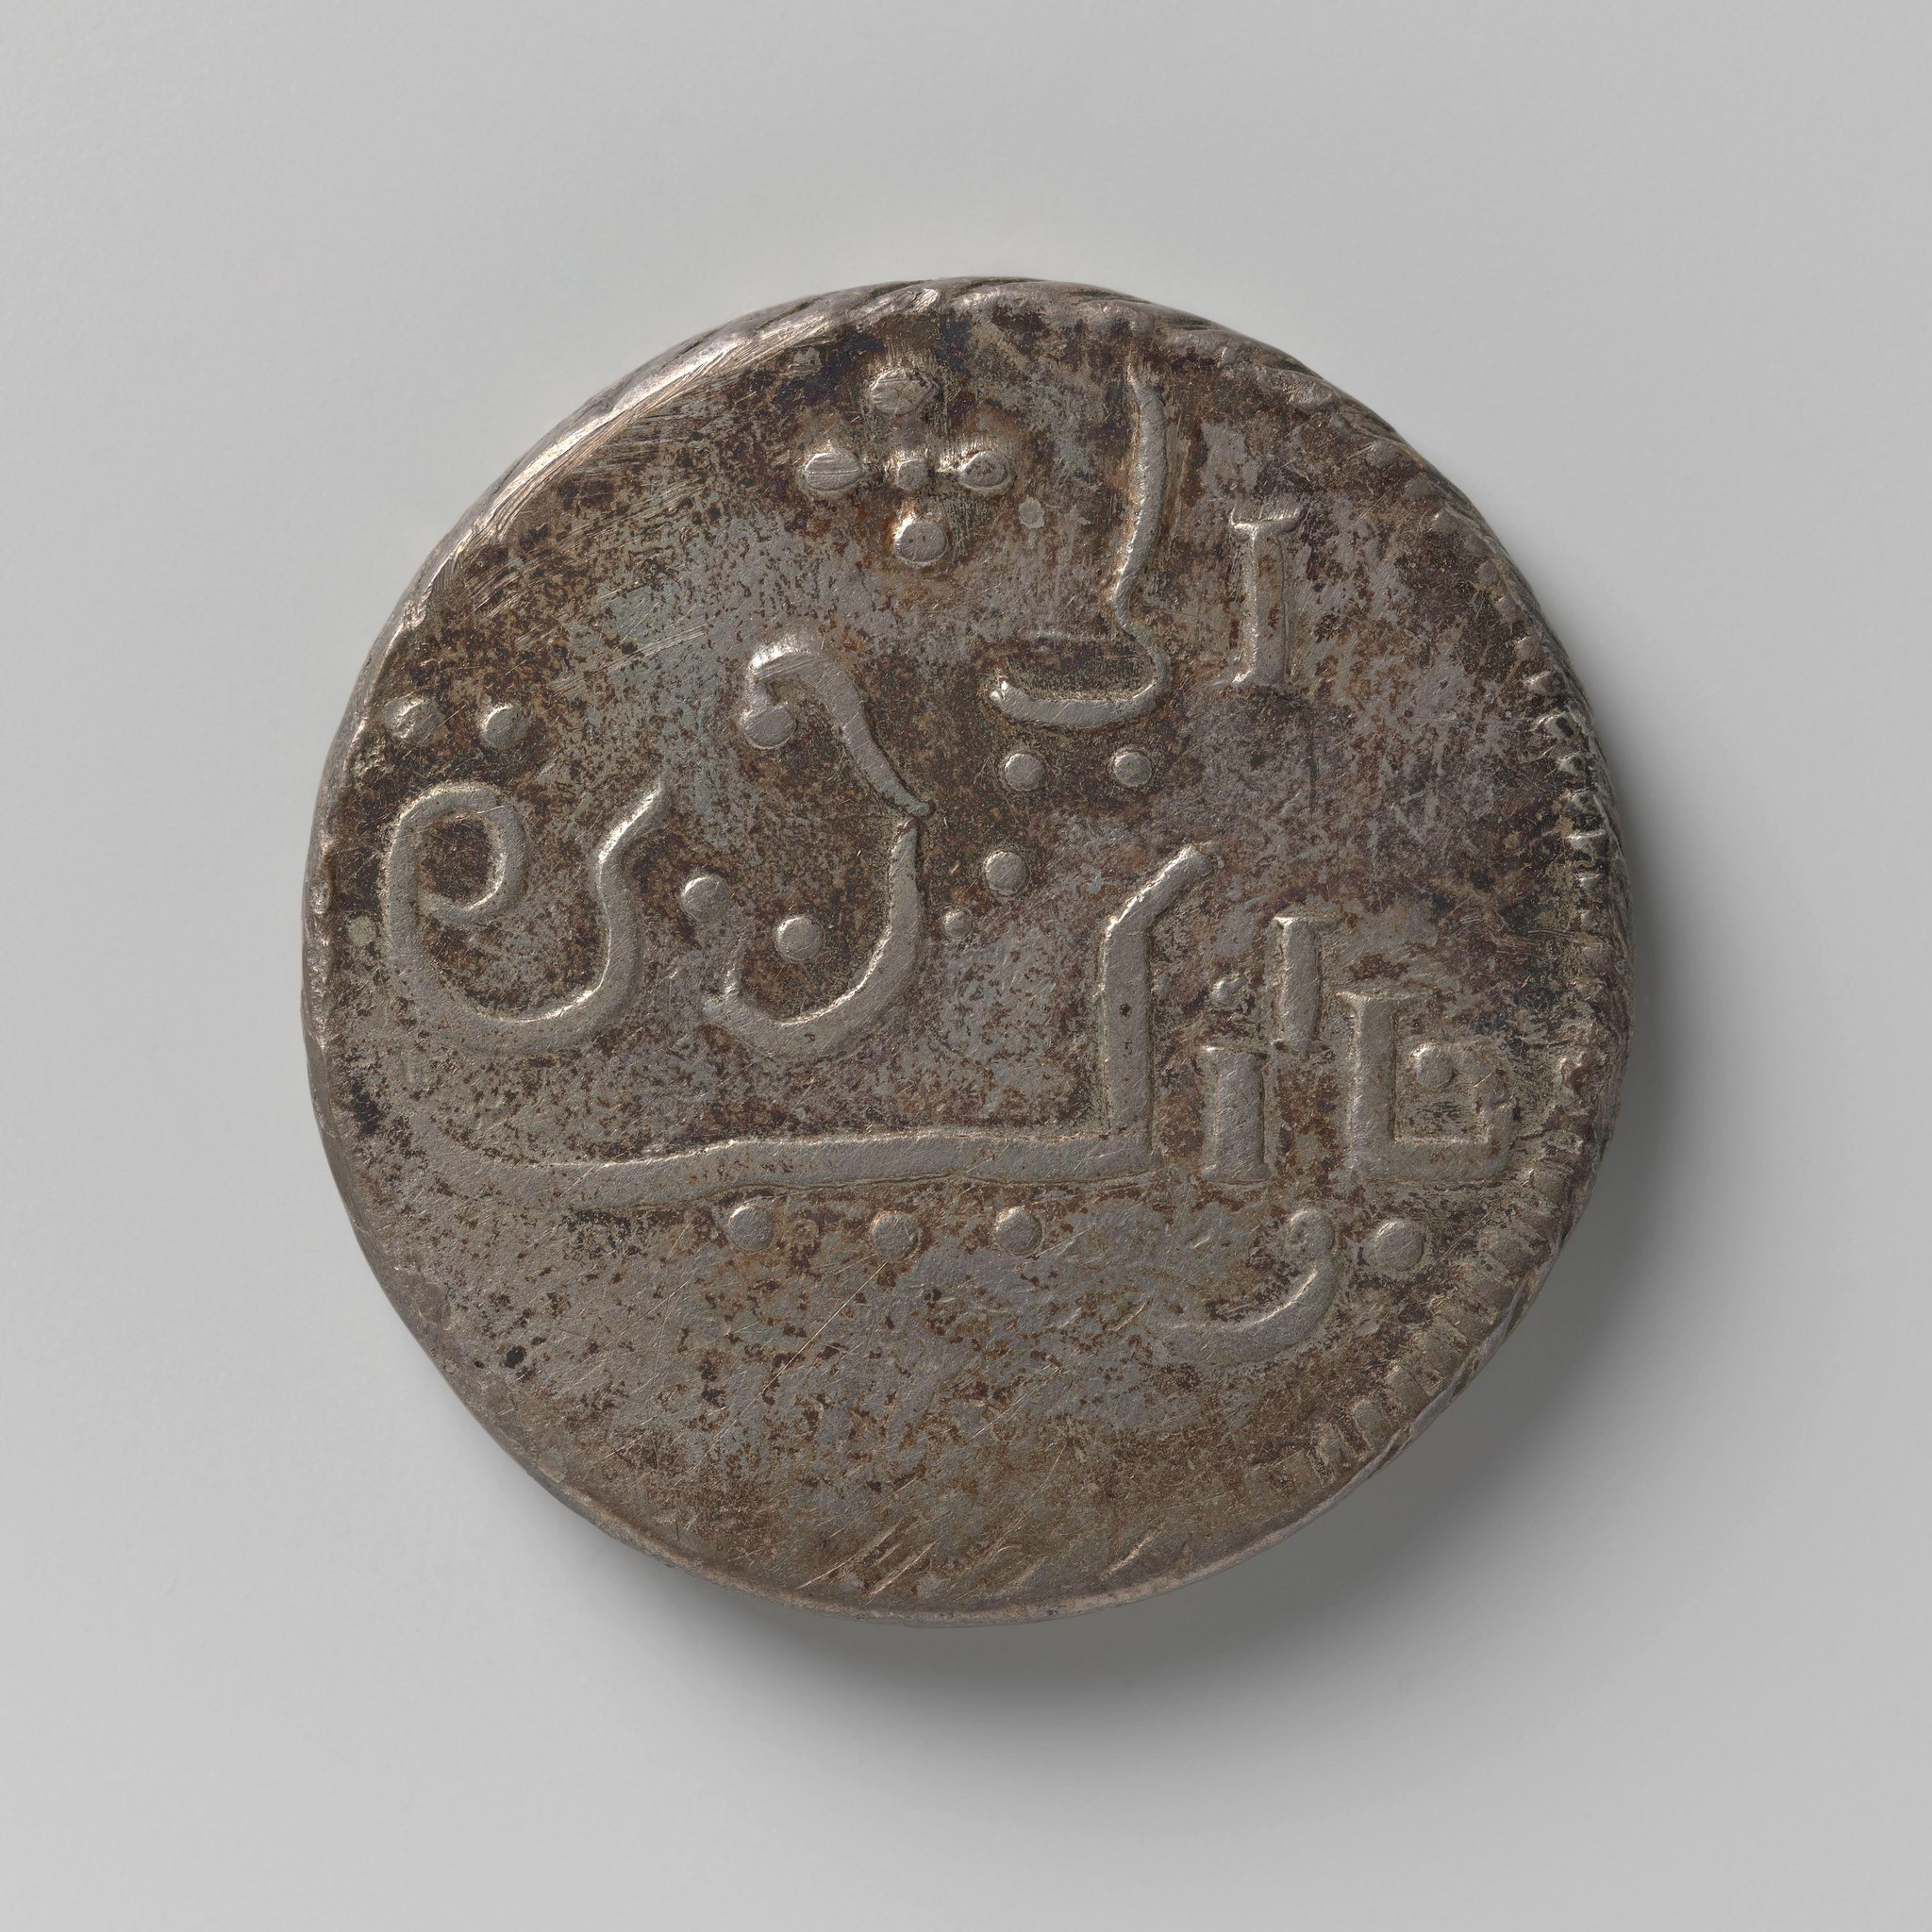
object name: coin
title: Zilveren ropij van de VOC uit Java, 1766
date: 1766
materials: silver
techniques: striking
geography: batavia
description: Zilveren munt. Voorzijde: tweeregelig opschrift in Arabische letters. Daarboven muntteken en daaronder jaartal. Keerzijde: drieregelig opschrift in Arabische letters. Kabelrand.